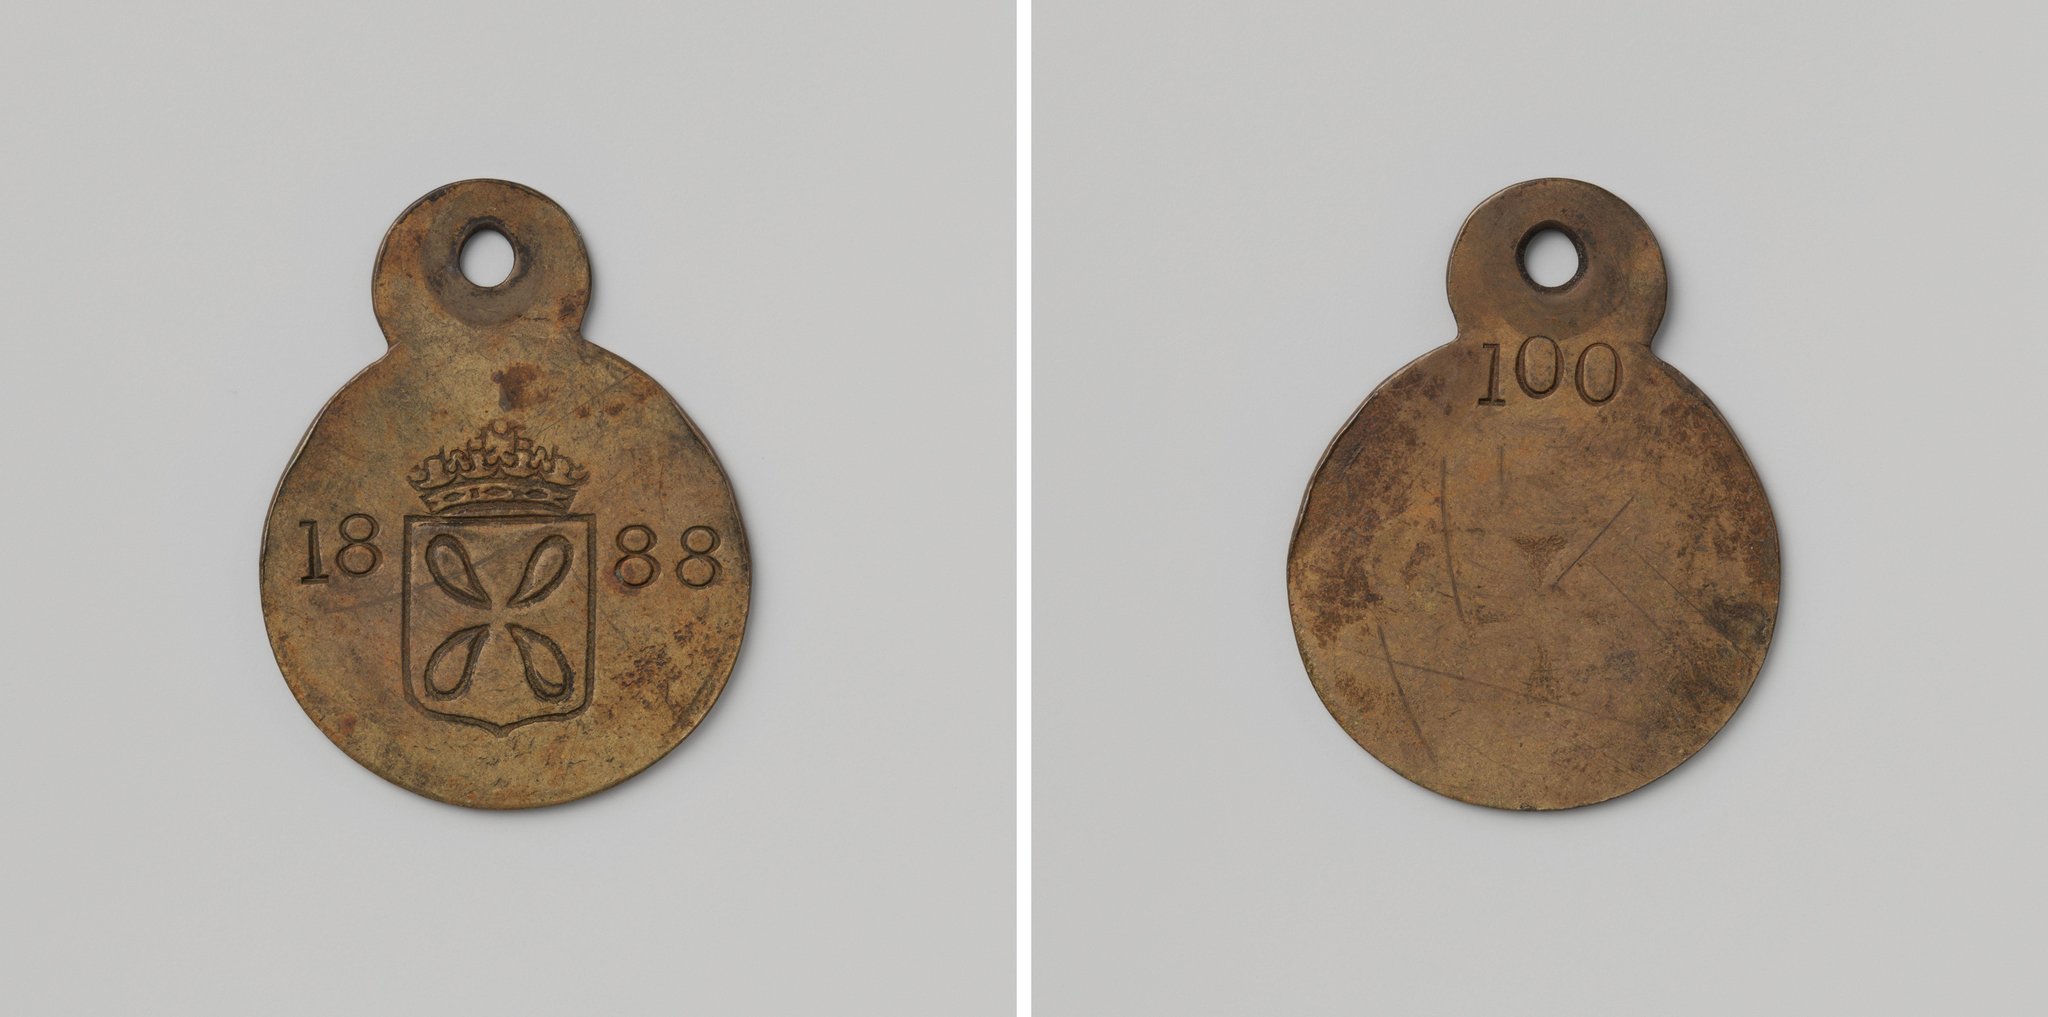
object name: tax token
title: Loodje met no. 100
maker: Anonymous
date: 1888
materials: brass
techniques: striking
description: loodje aan draagring. Voorzijde: gekroond wapenschild tussen jaartal. Keerzijde: cijfer 100